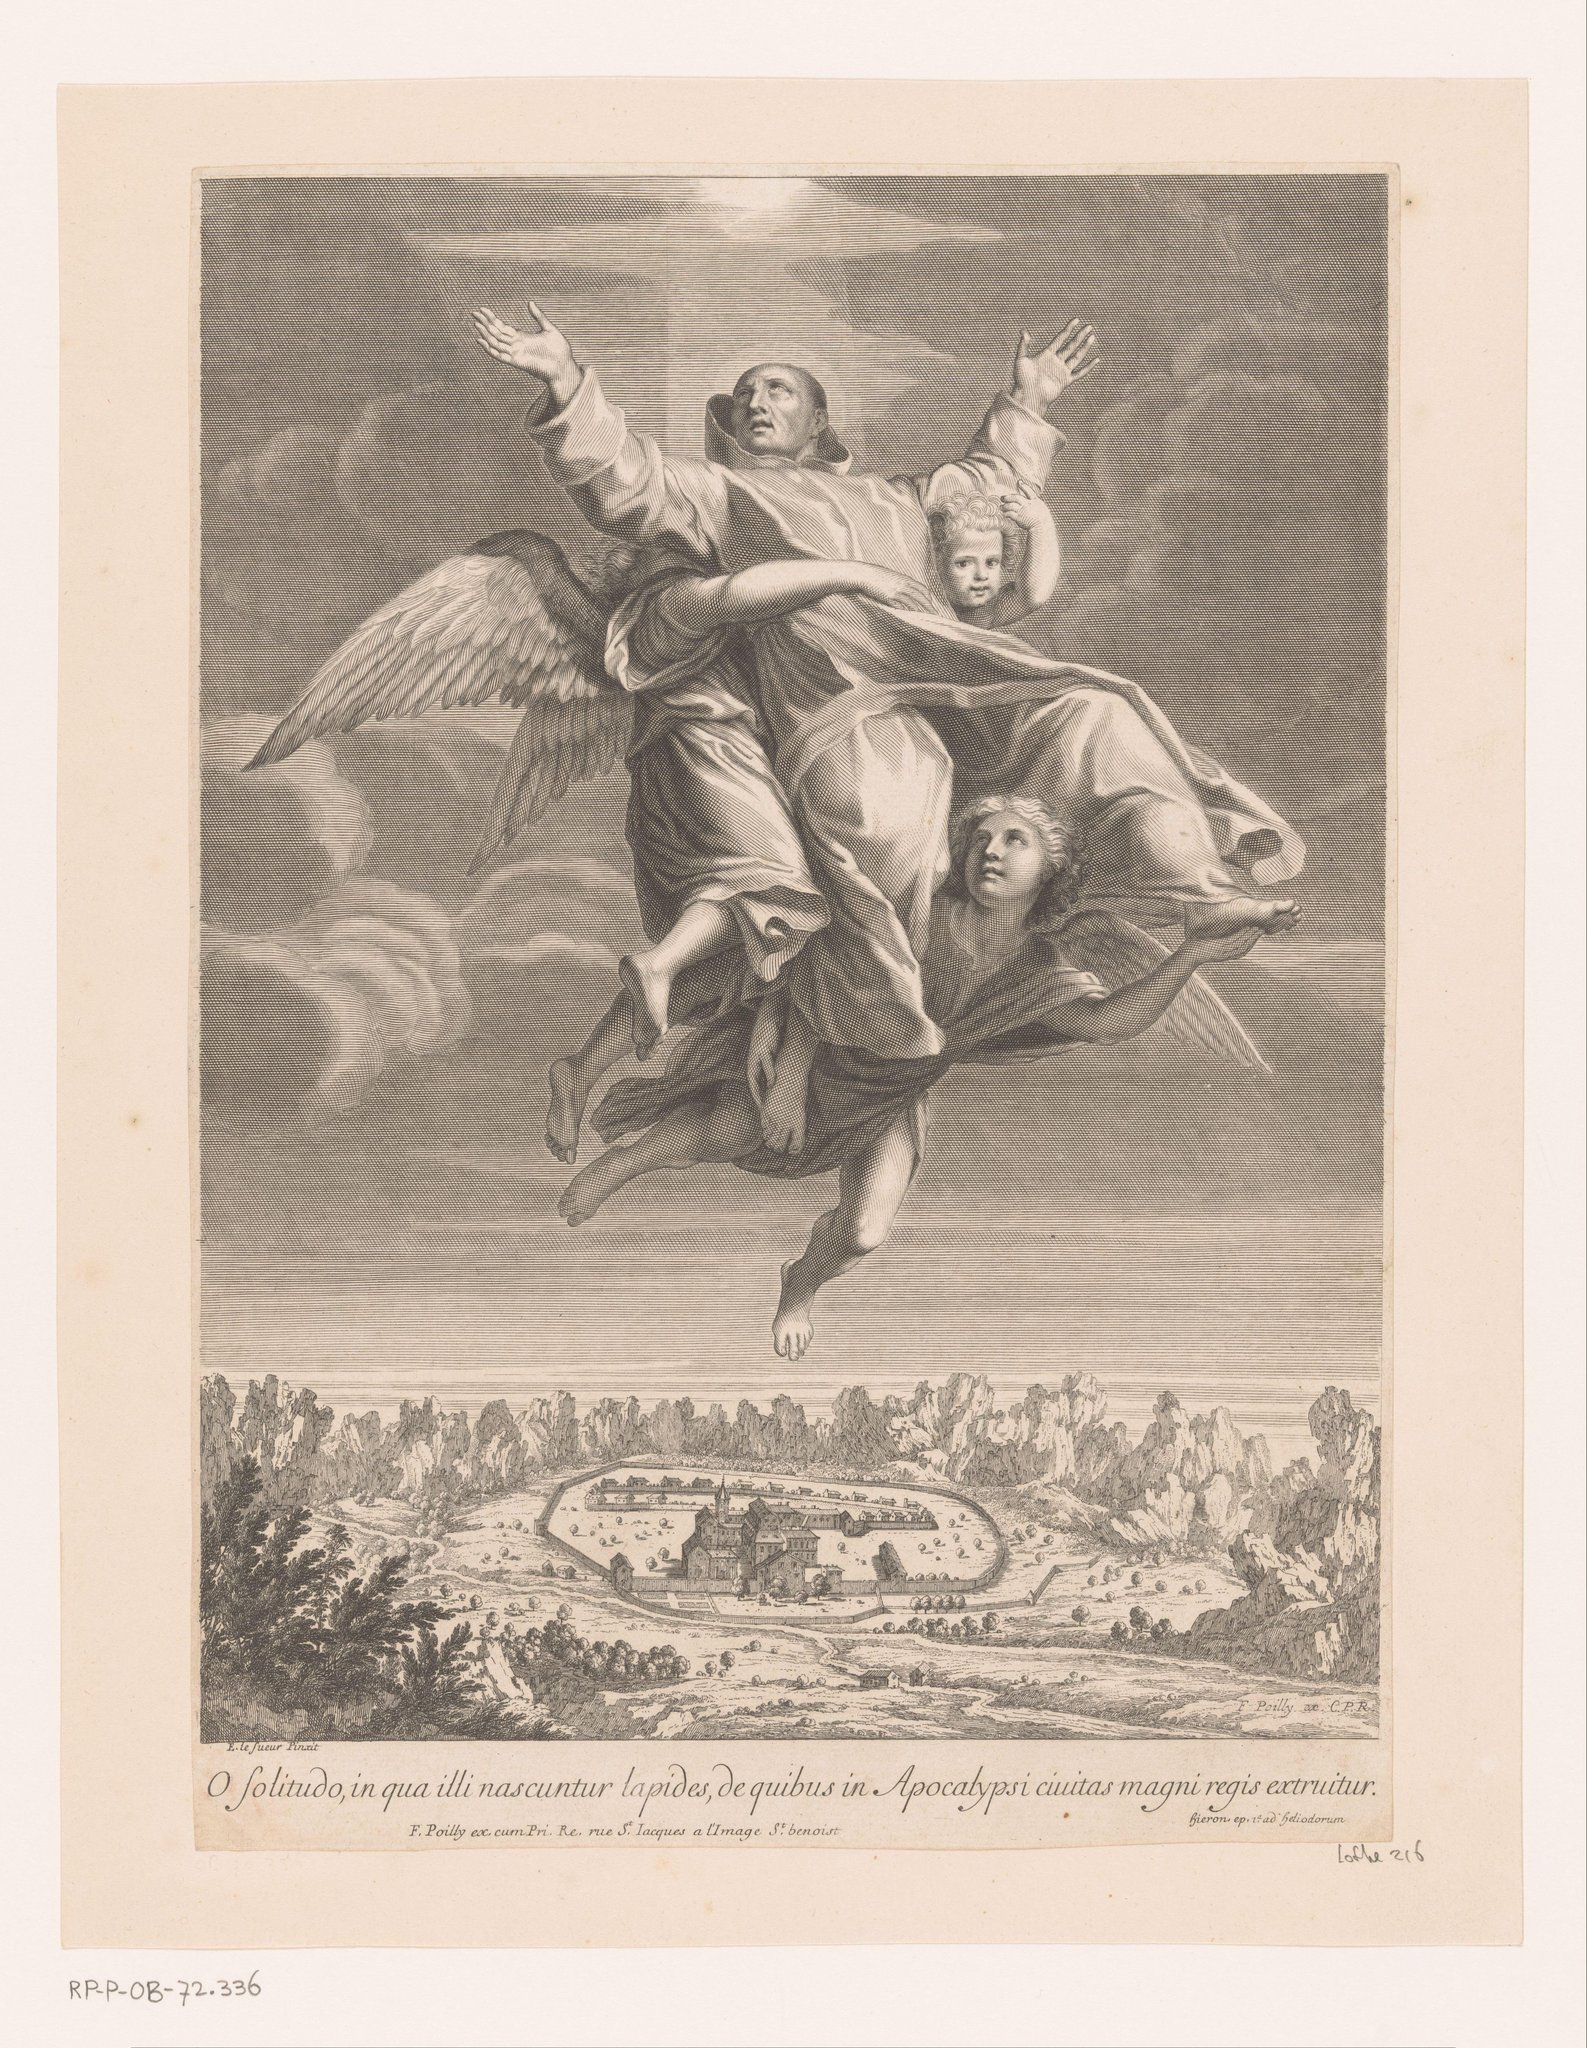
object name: print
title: Heilige Bruno ten hemel gedragen door drie engelen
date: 1632-1693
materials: paper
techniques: engraving, etching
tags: the founder of the order of the carthusians, bruno; possible attributes: cross, finger at lips, lily, mitre at his feet, olive-branch, ray of light, skull, (seven) star(s)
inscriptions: collector's mark: Lugt 240